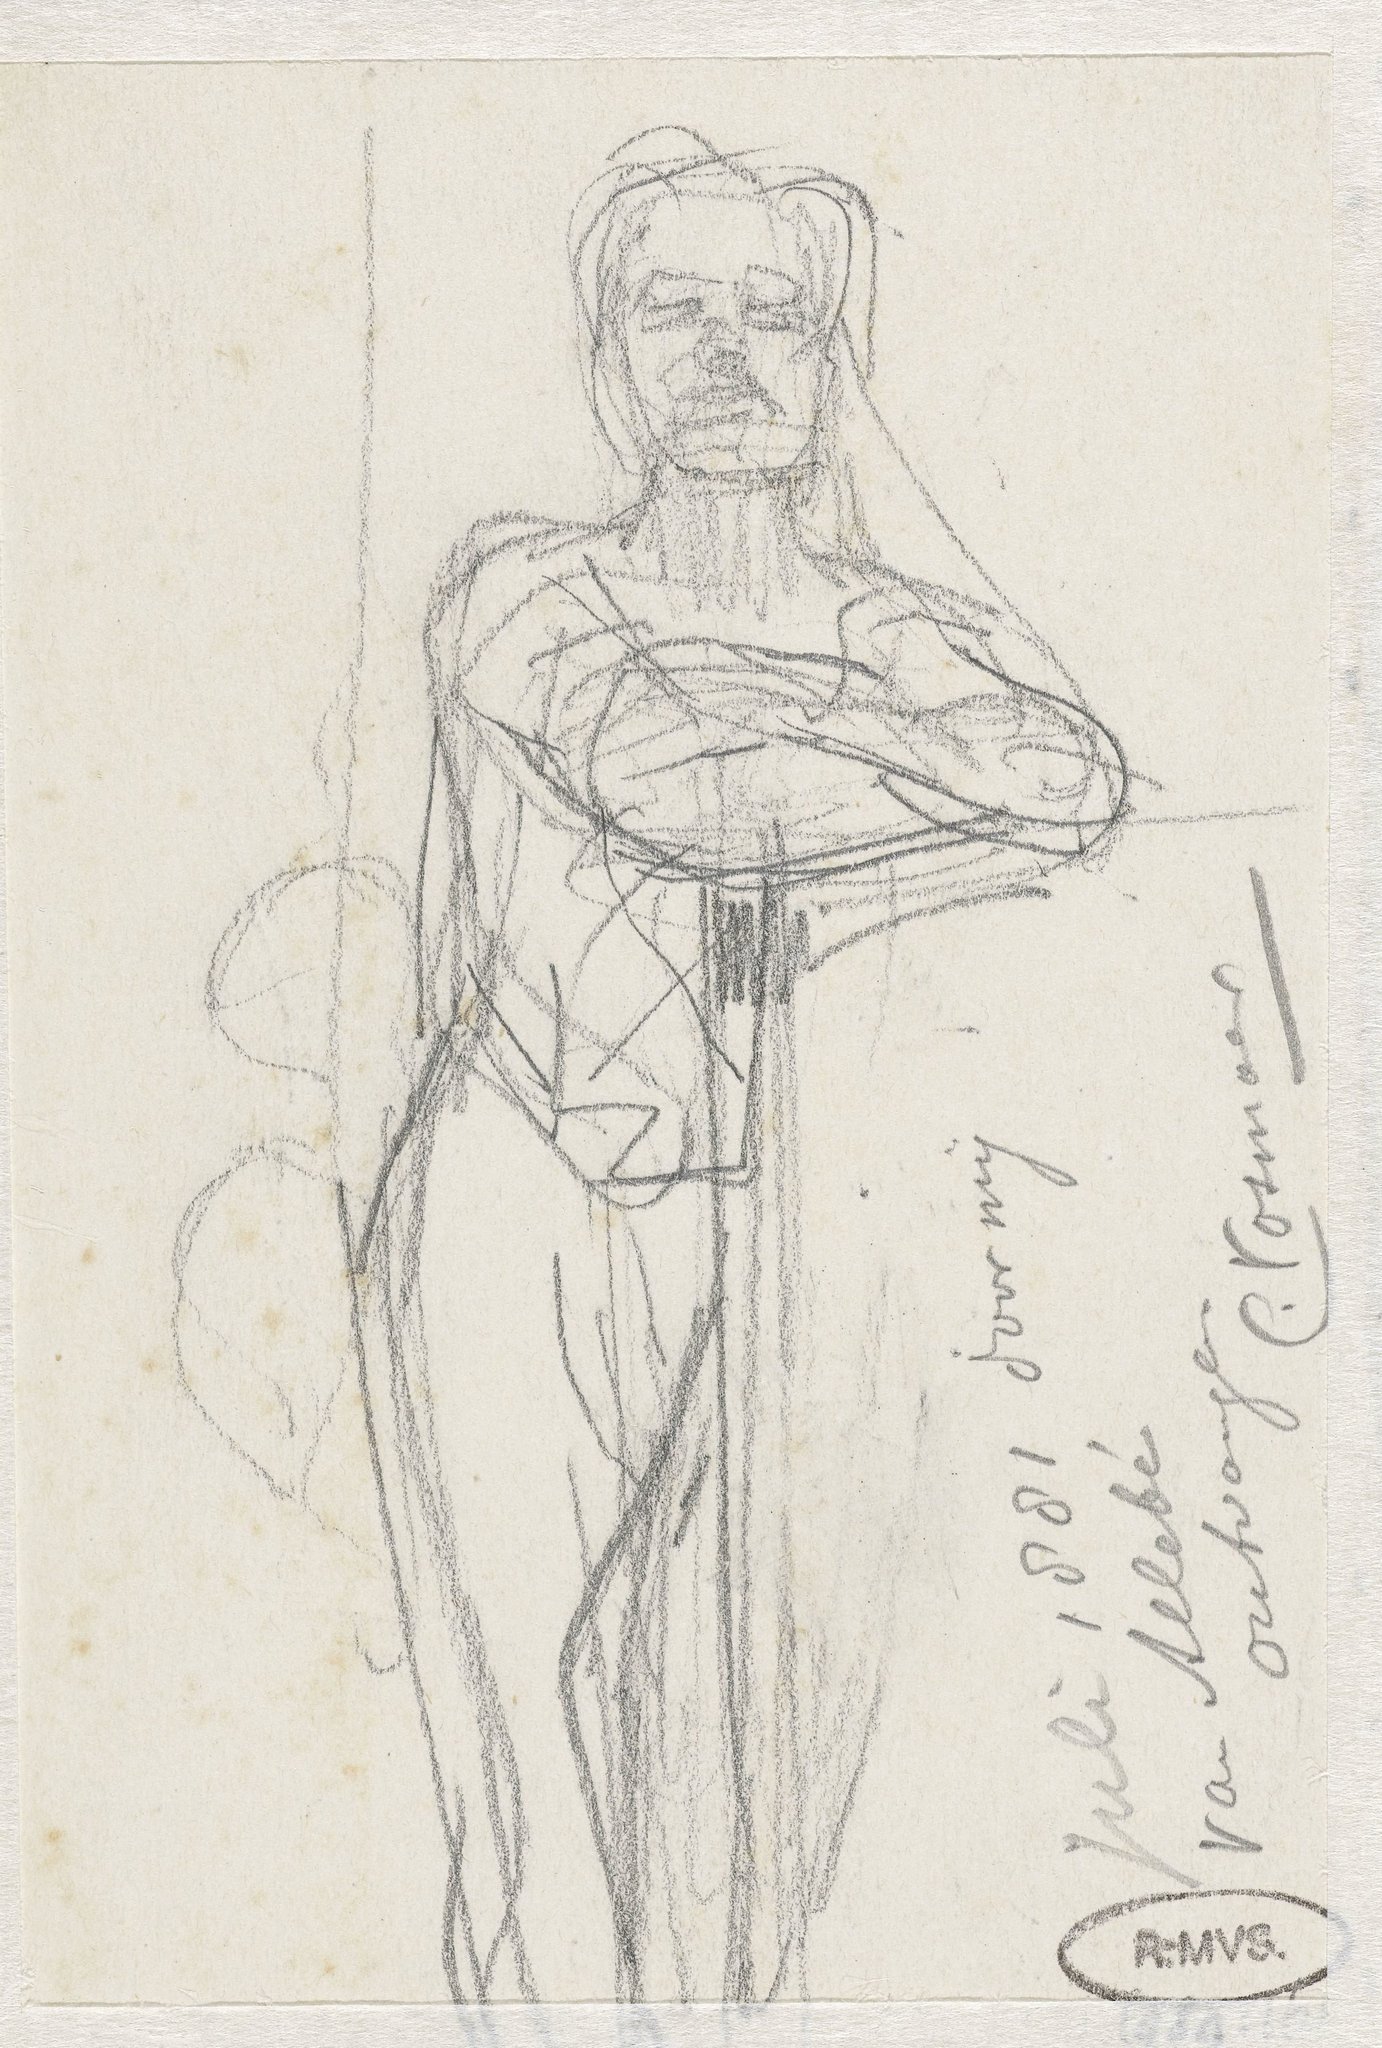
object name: drawing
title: Staande figuur, de armen over elkaar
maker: august allebé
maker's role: draughtsman, print maker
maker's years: 1838-1927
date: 1848-1927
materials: paper, pencil